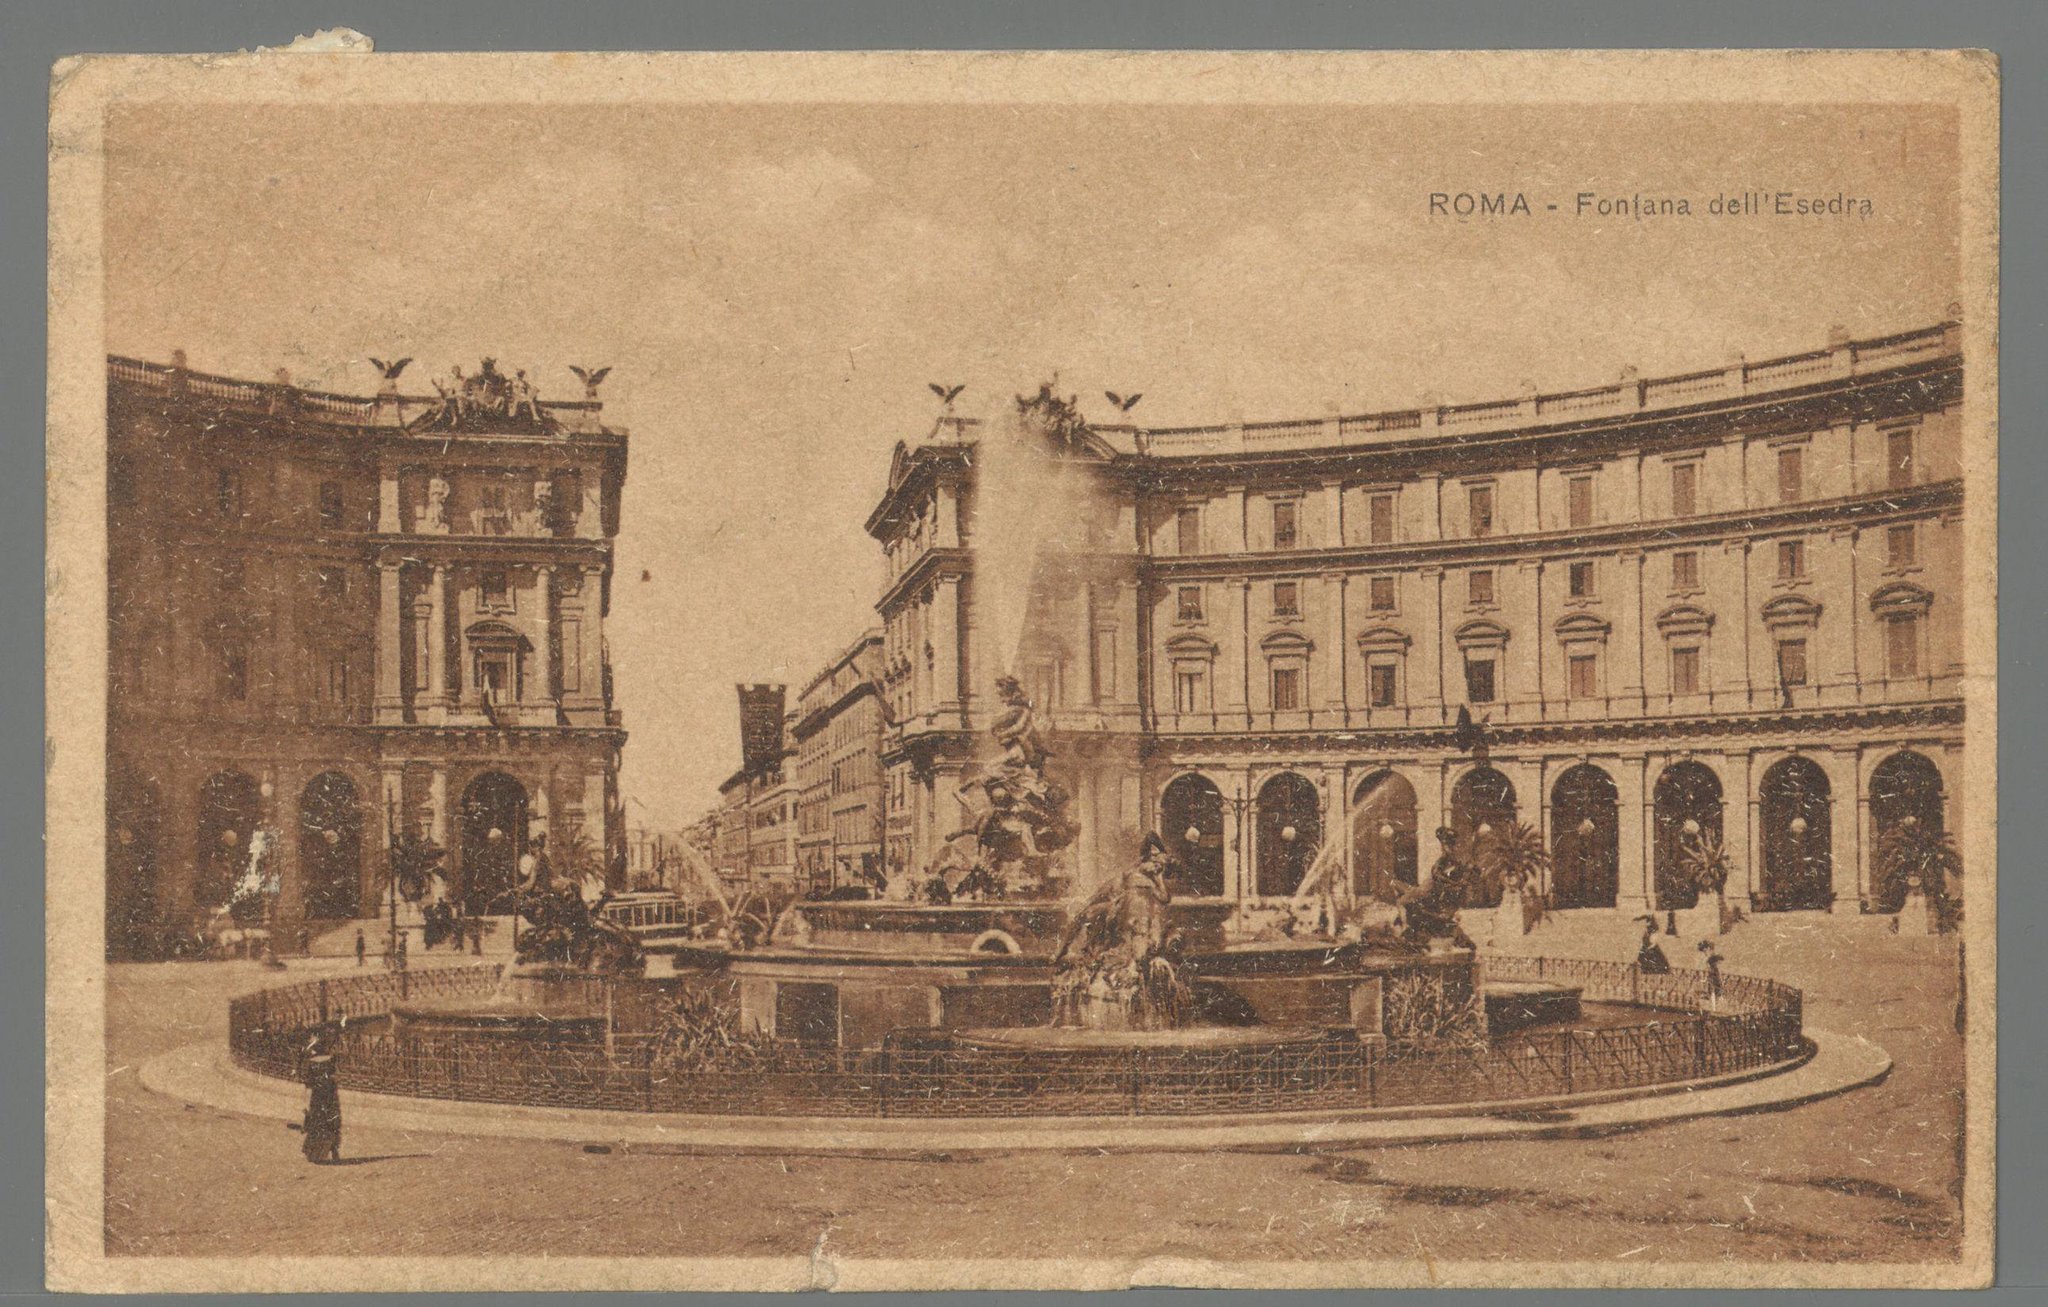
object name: photomechanical print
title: Roma. Fontana dell'Esedra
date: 1906-1920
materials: cardboard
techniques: photograph, writing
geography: terni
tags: square, place, circus, etc. (+ city(-scape) with figures, staffage), ornamental fountain (+ city(-scape) with figures, staffage)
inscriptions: signature: ‘(...) V.R.’, postage stamp